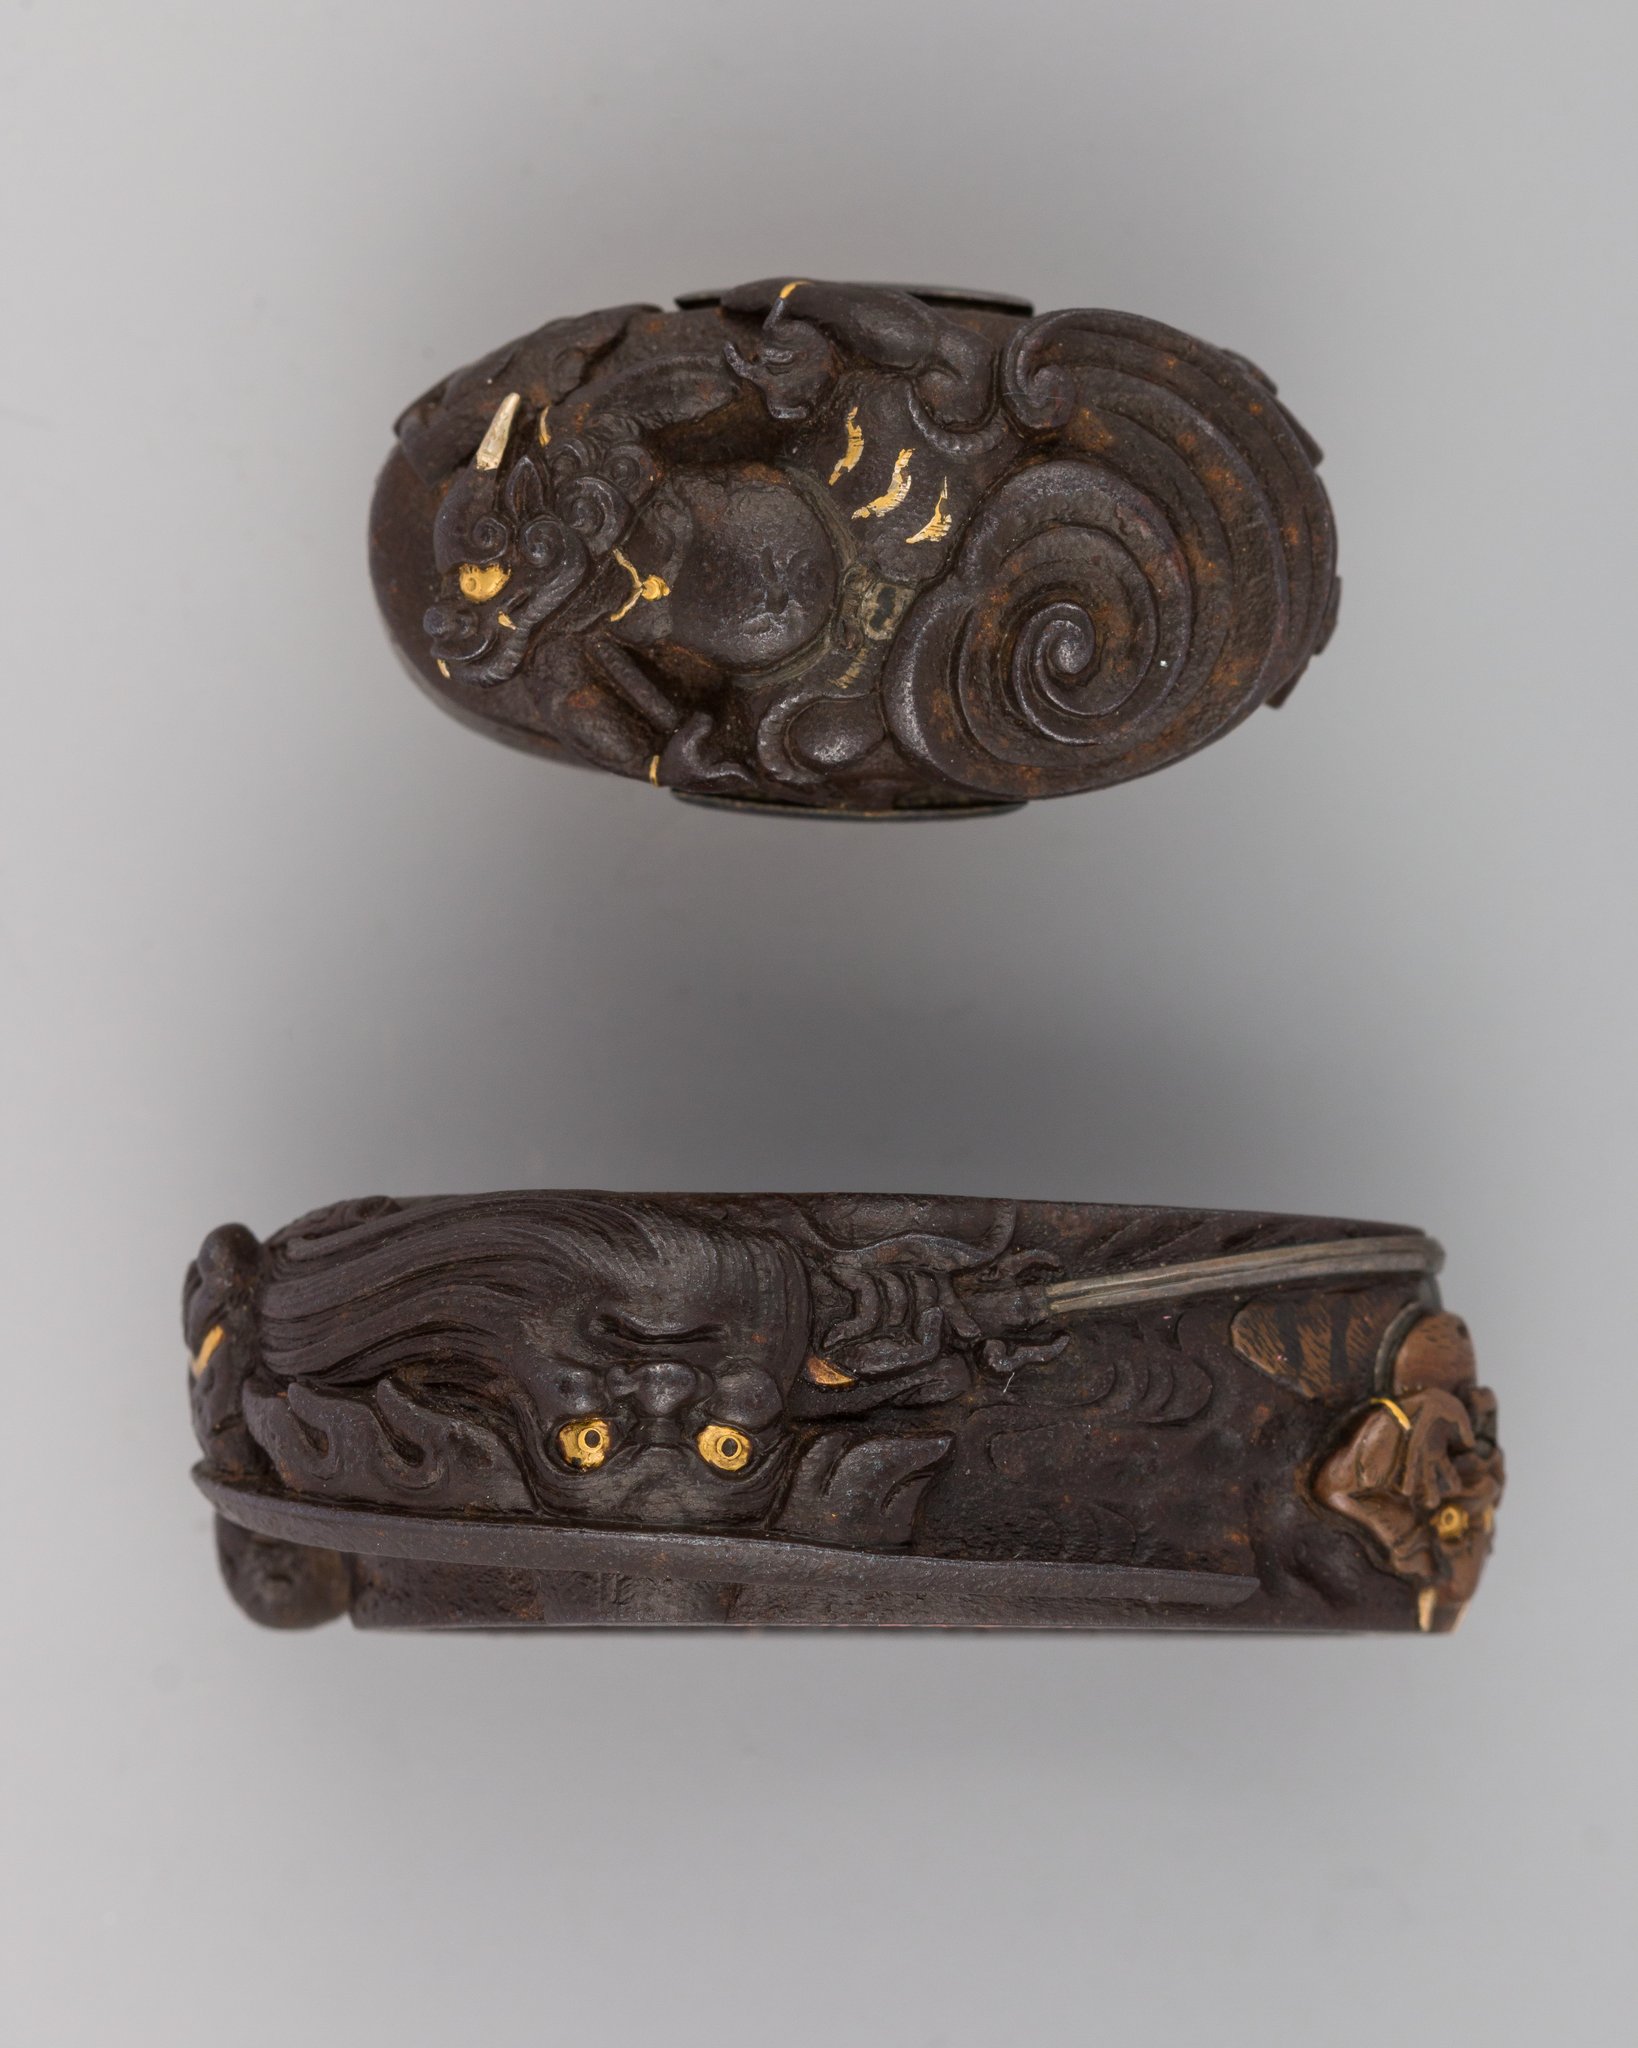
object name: sword hilt collar and pommel fuchigashira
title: Sword-Hilt Collar and Pommel (Fuchigashira)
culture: japanese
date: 1701-1800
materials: gold, iron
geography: japan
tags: men,demons